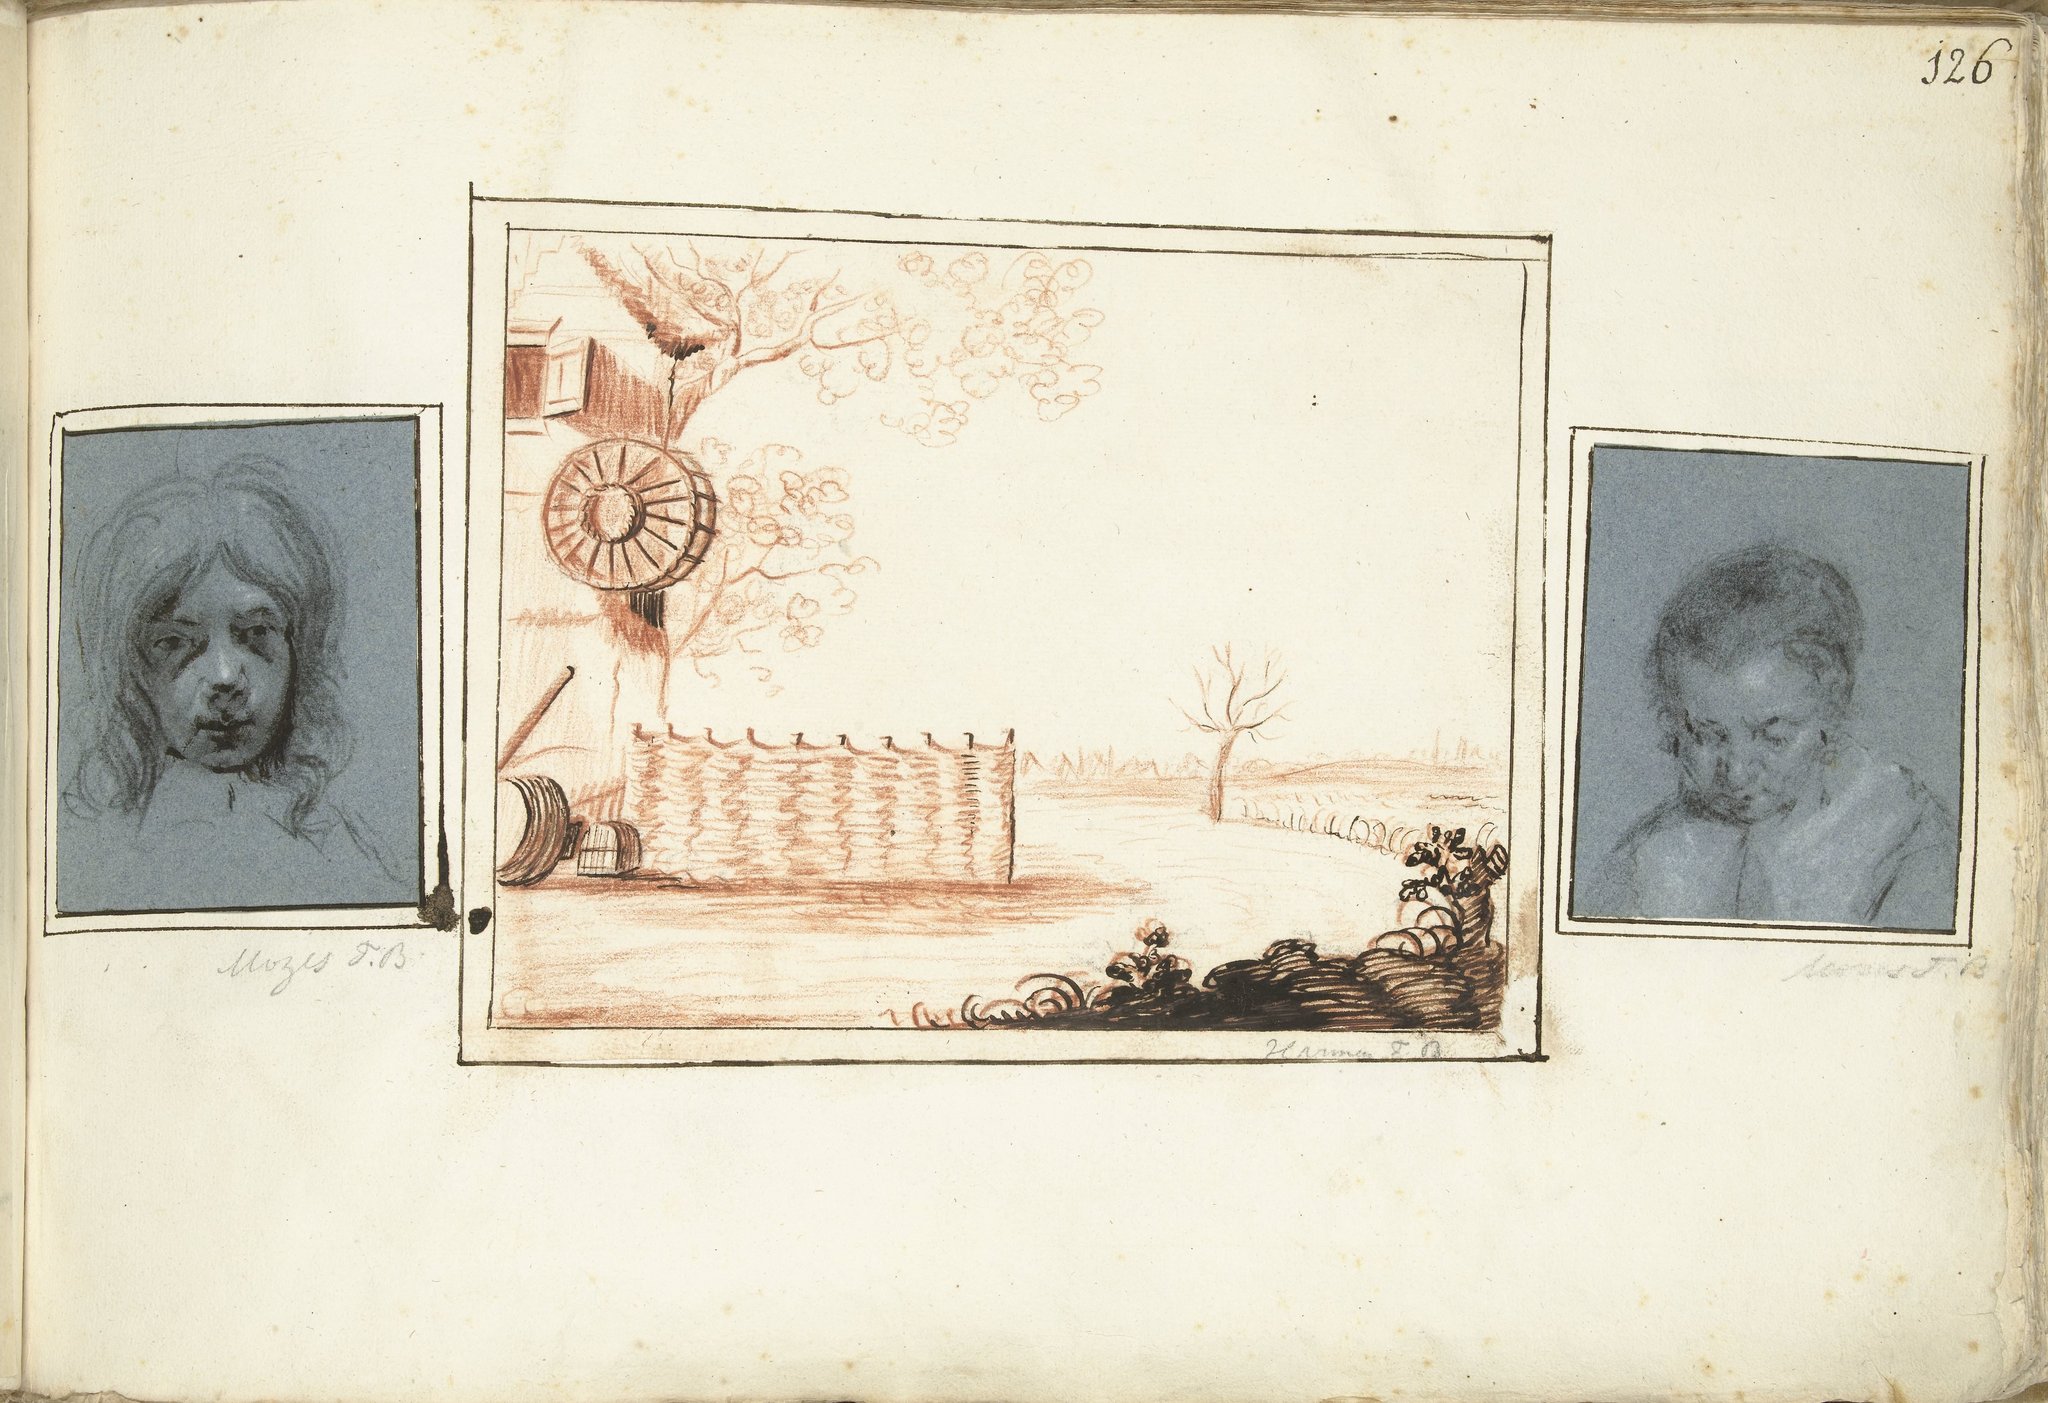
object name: drawing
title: Jongenshoofd, boerenerf en portret van een vrouw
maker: moses ter borch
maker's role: draughtsman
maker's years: 1645-1667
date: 1643-1687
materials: chalk, paper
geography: zwolle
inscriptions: annotation: ‘Mozes T.B.’, annotation: ‘Mozes T.B.’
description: Drie tekeningen naast elkaar op een blad geplakt.